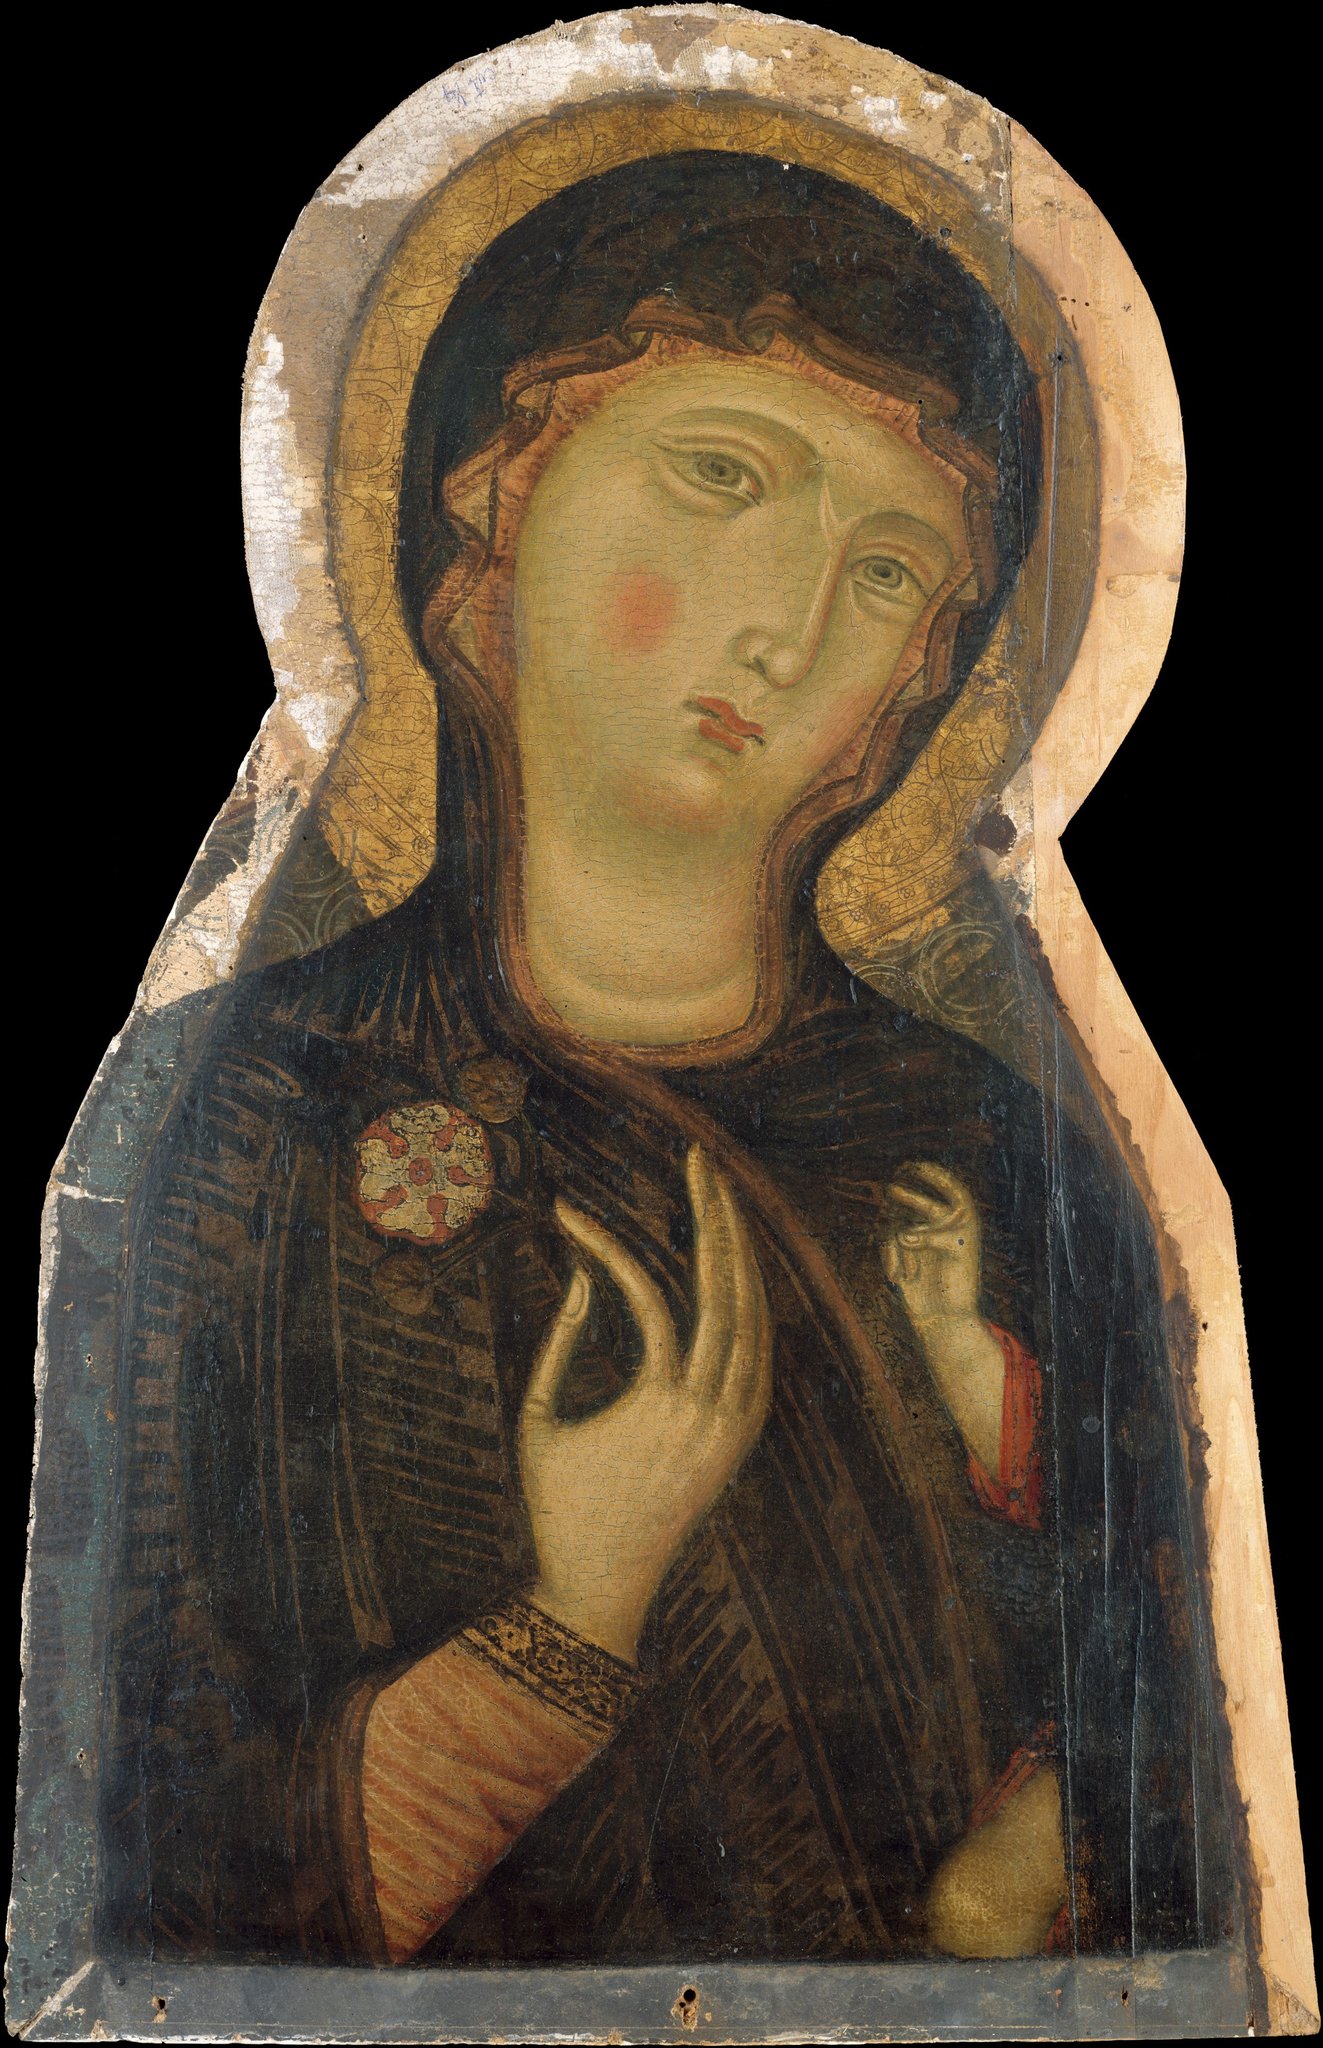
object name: painting fragment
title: Madonna and Child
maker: master of the magdalen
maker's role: artist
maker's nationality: italian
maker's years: 1265-1295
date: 1280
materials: paint, wood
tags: madonna and child